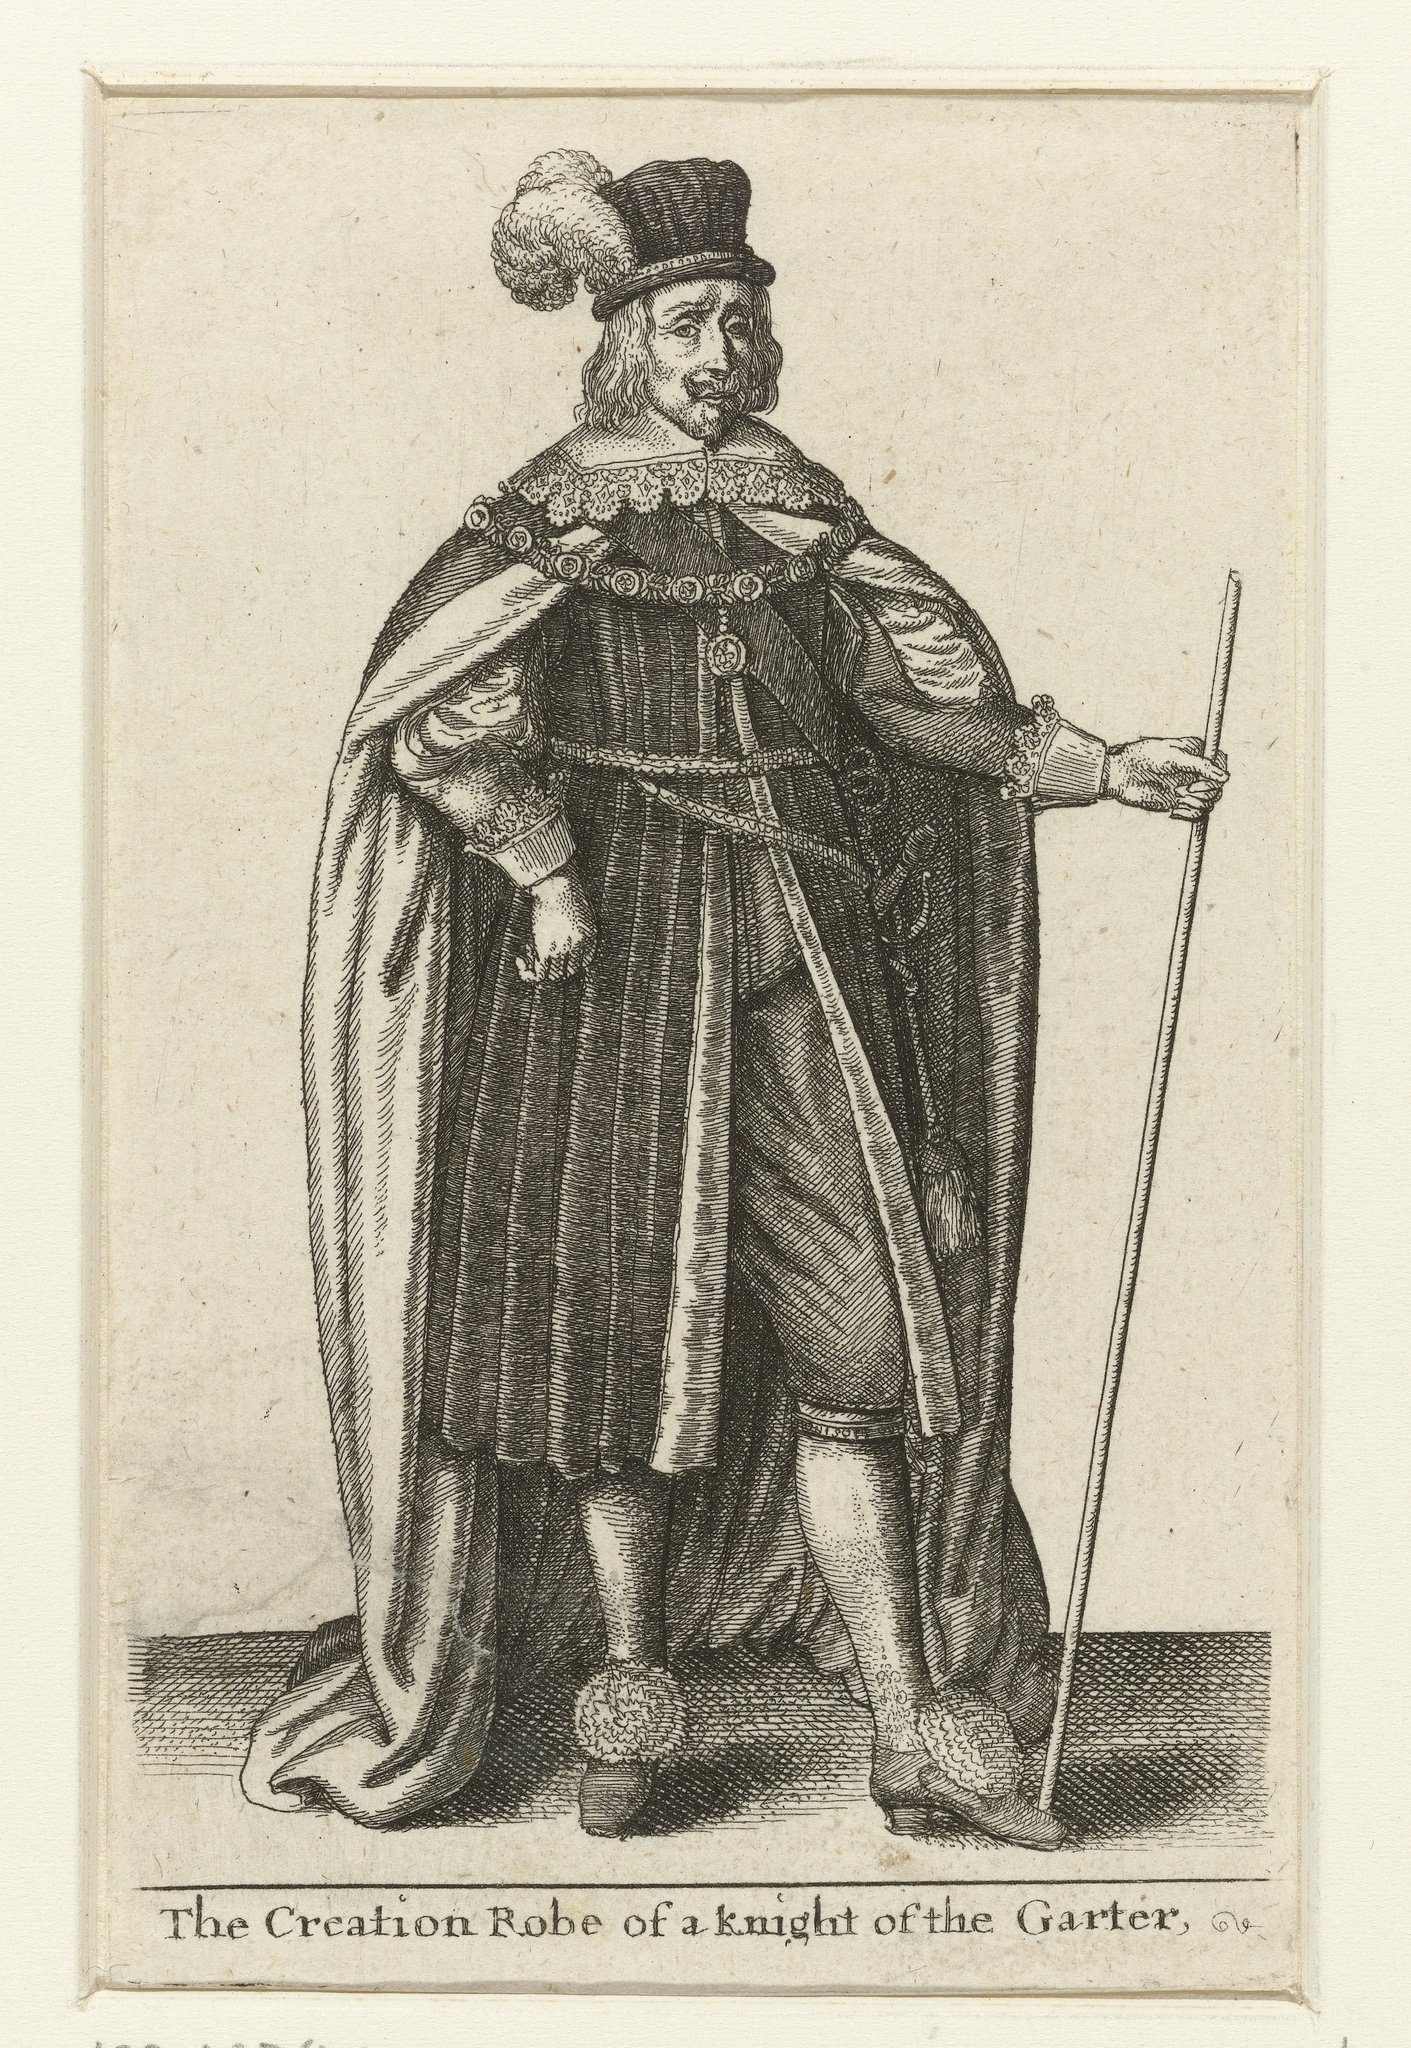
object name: print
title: William Cecil, graaf van Salisbury, in ceremoniële kledij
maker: wenceslaus hollar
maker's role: draughtsman, print maker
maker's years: 1607-1677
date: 1617-1677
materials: paper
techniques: etching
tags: clothes for special purposes, nobility and patriciate; chivalry, knighthood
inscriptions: collector's mark: Lugt 654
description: De prent maakt deel uit van een negendelige serie met ceremoniële kledij van de Engelse adel. De prent (1e staat) werd als onderdeel van bovengenoemde serie mogelijk door Thomas Jenner opgenomen onder de titel "The Creation Robes of the Nobility in 9-Plates' in zijn 'A Catalogue of Severall Bookes', 1662. Hollar werkte naar ontwerpen uit Richard Glover's 'Nobilitas politica vel civilis', Londen, 1608.